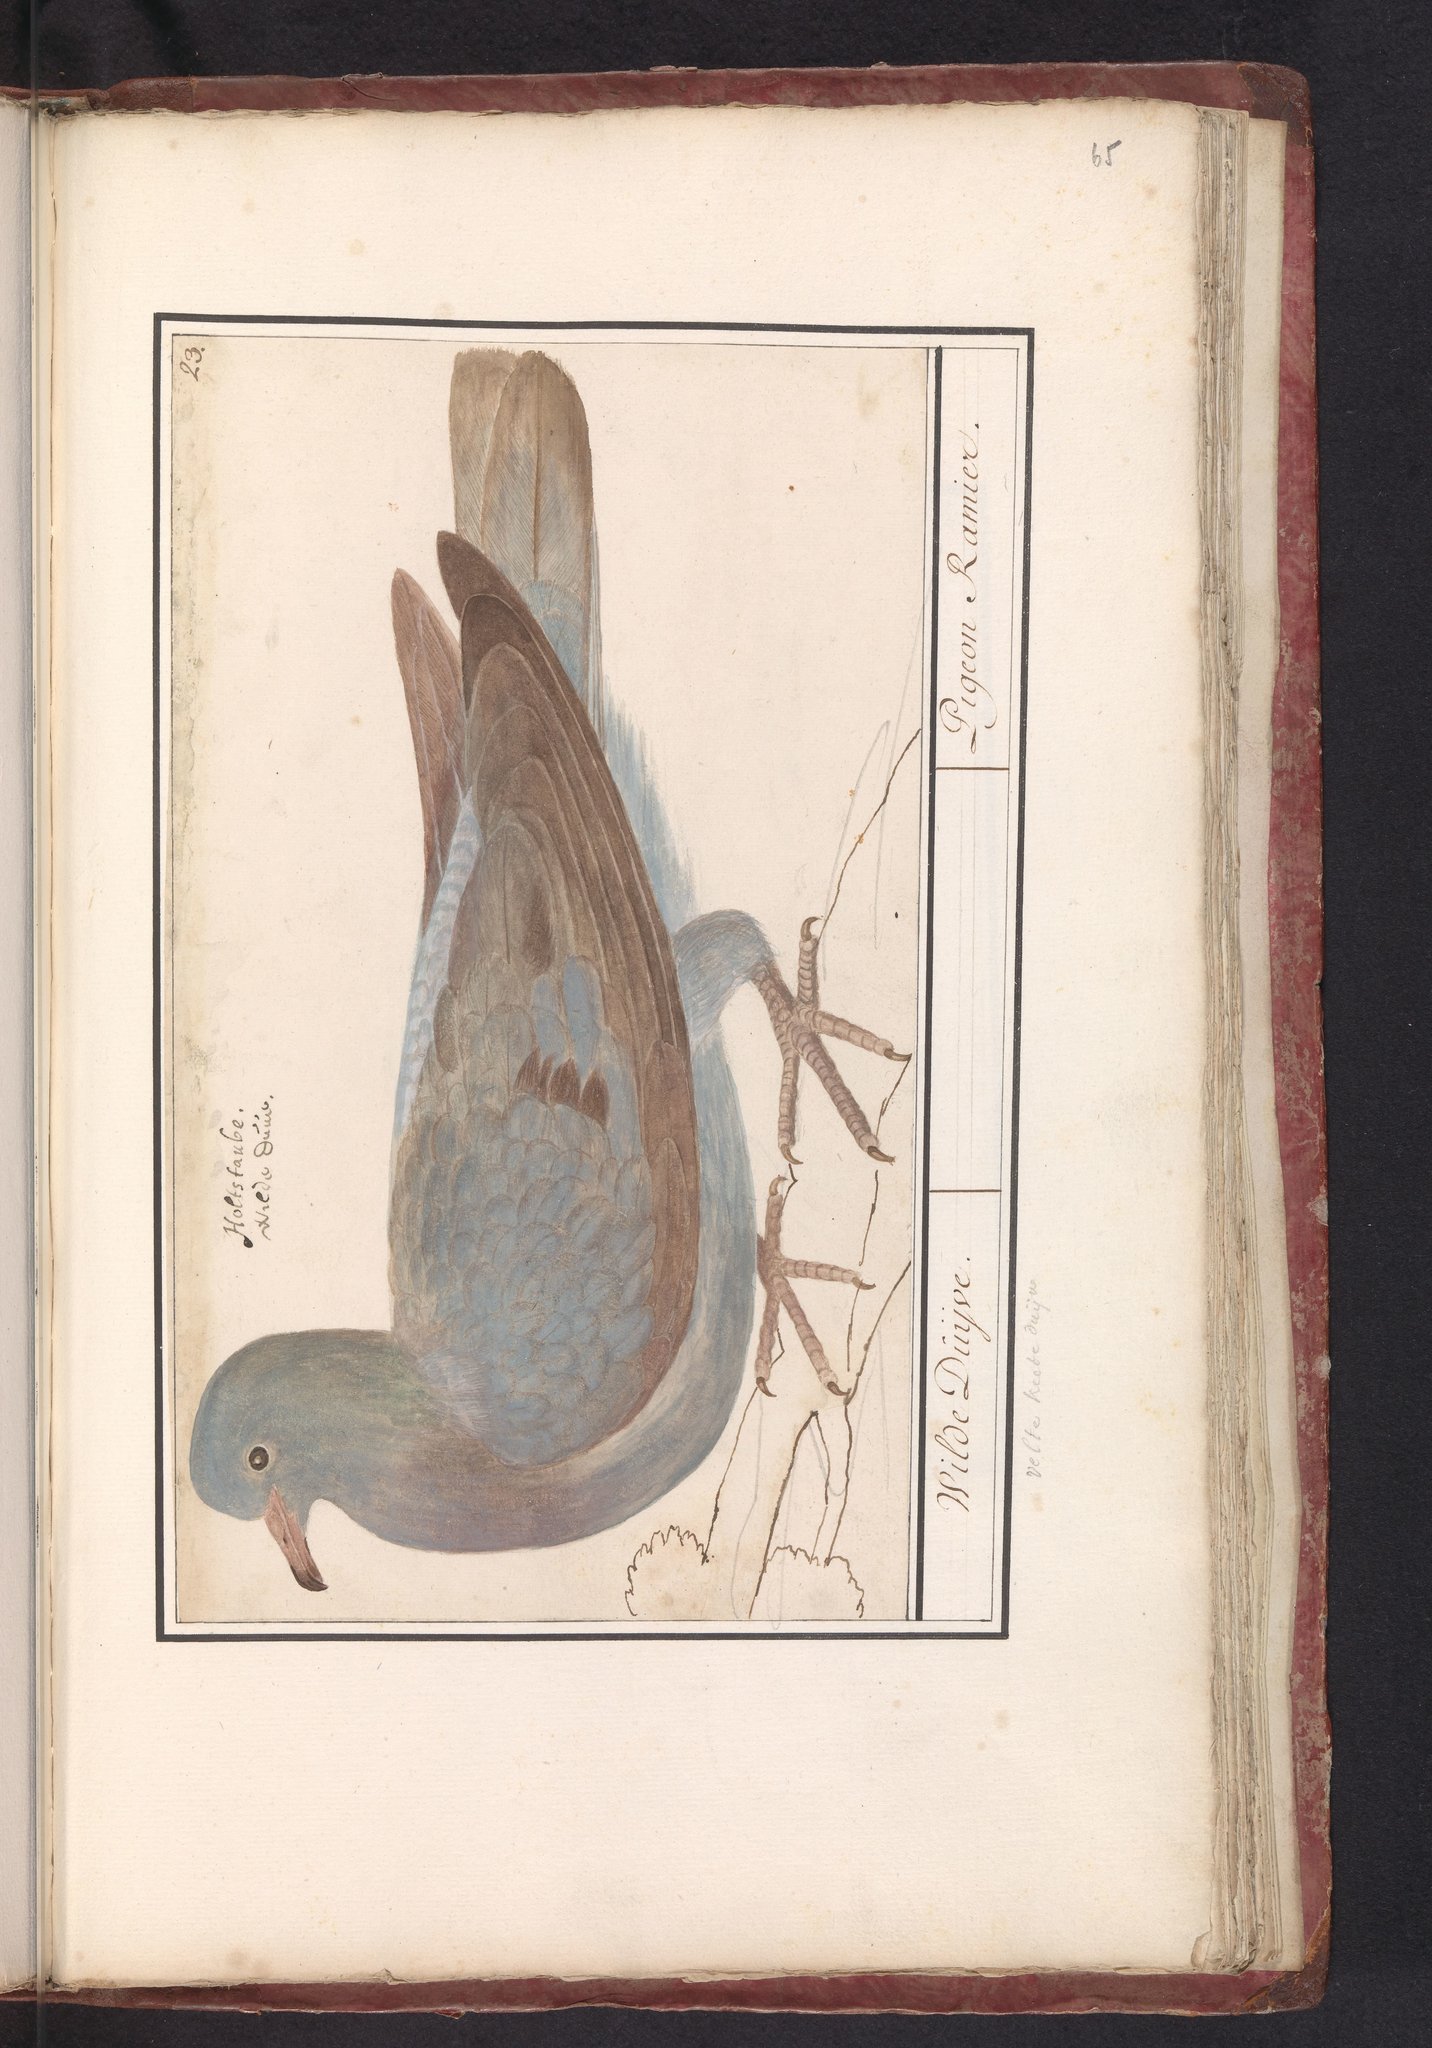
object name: drawing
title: Houtduif (Columba palumbus)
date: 1596-1610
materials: paint, ink, paper, pencil, watercolor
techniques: brush, pen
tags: other birds: dove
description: Houtduif. Genummerd rechtsboven: 23. Linksboven de naam in twee talen. Onderdeel van het eerste album met tekeningen van vogels. Derde van twaalf albums met tekeningen van dieren, vogels en planten bekend rond 1600, gemaakt in opdracht van keizer Rudolf II. Met toelichting in Nederlands, Latijn en Frans.